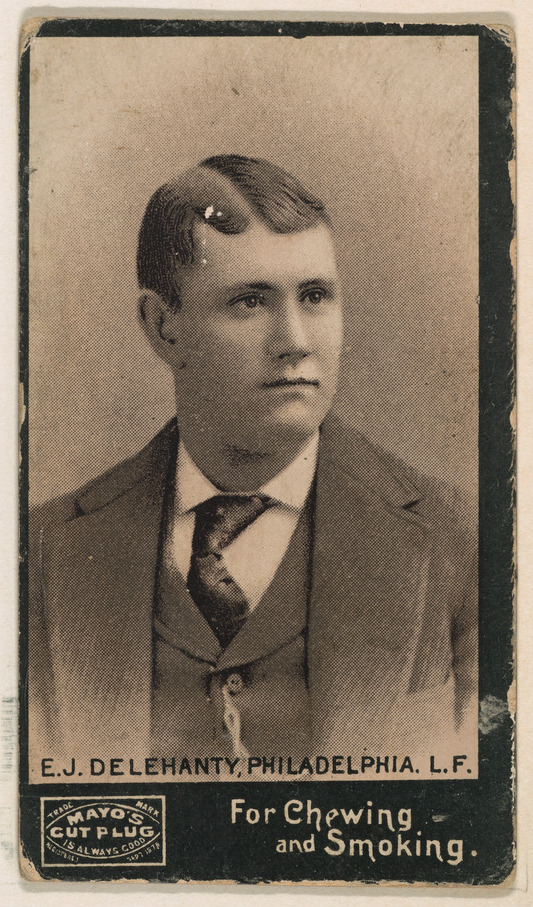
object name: print, baseball card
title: E. J. Delehanty, Left Field, Philadelphia, from Mayo's Cut Plug Baseball series (N300)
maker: p.h. mayo & brother, richmond, virginia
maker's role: publisher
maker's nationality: american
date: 1895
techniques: lithography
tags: men,portraits,baseball,athletes